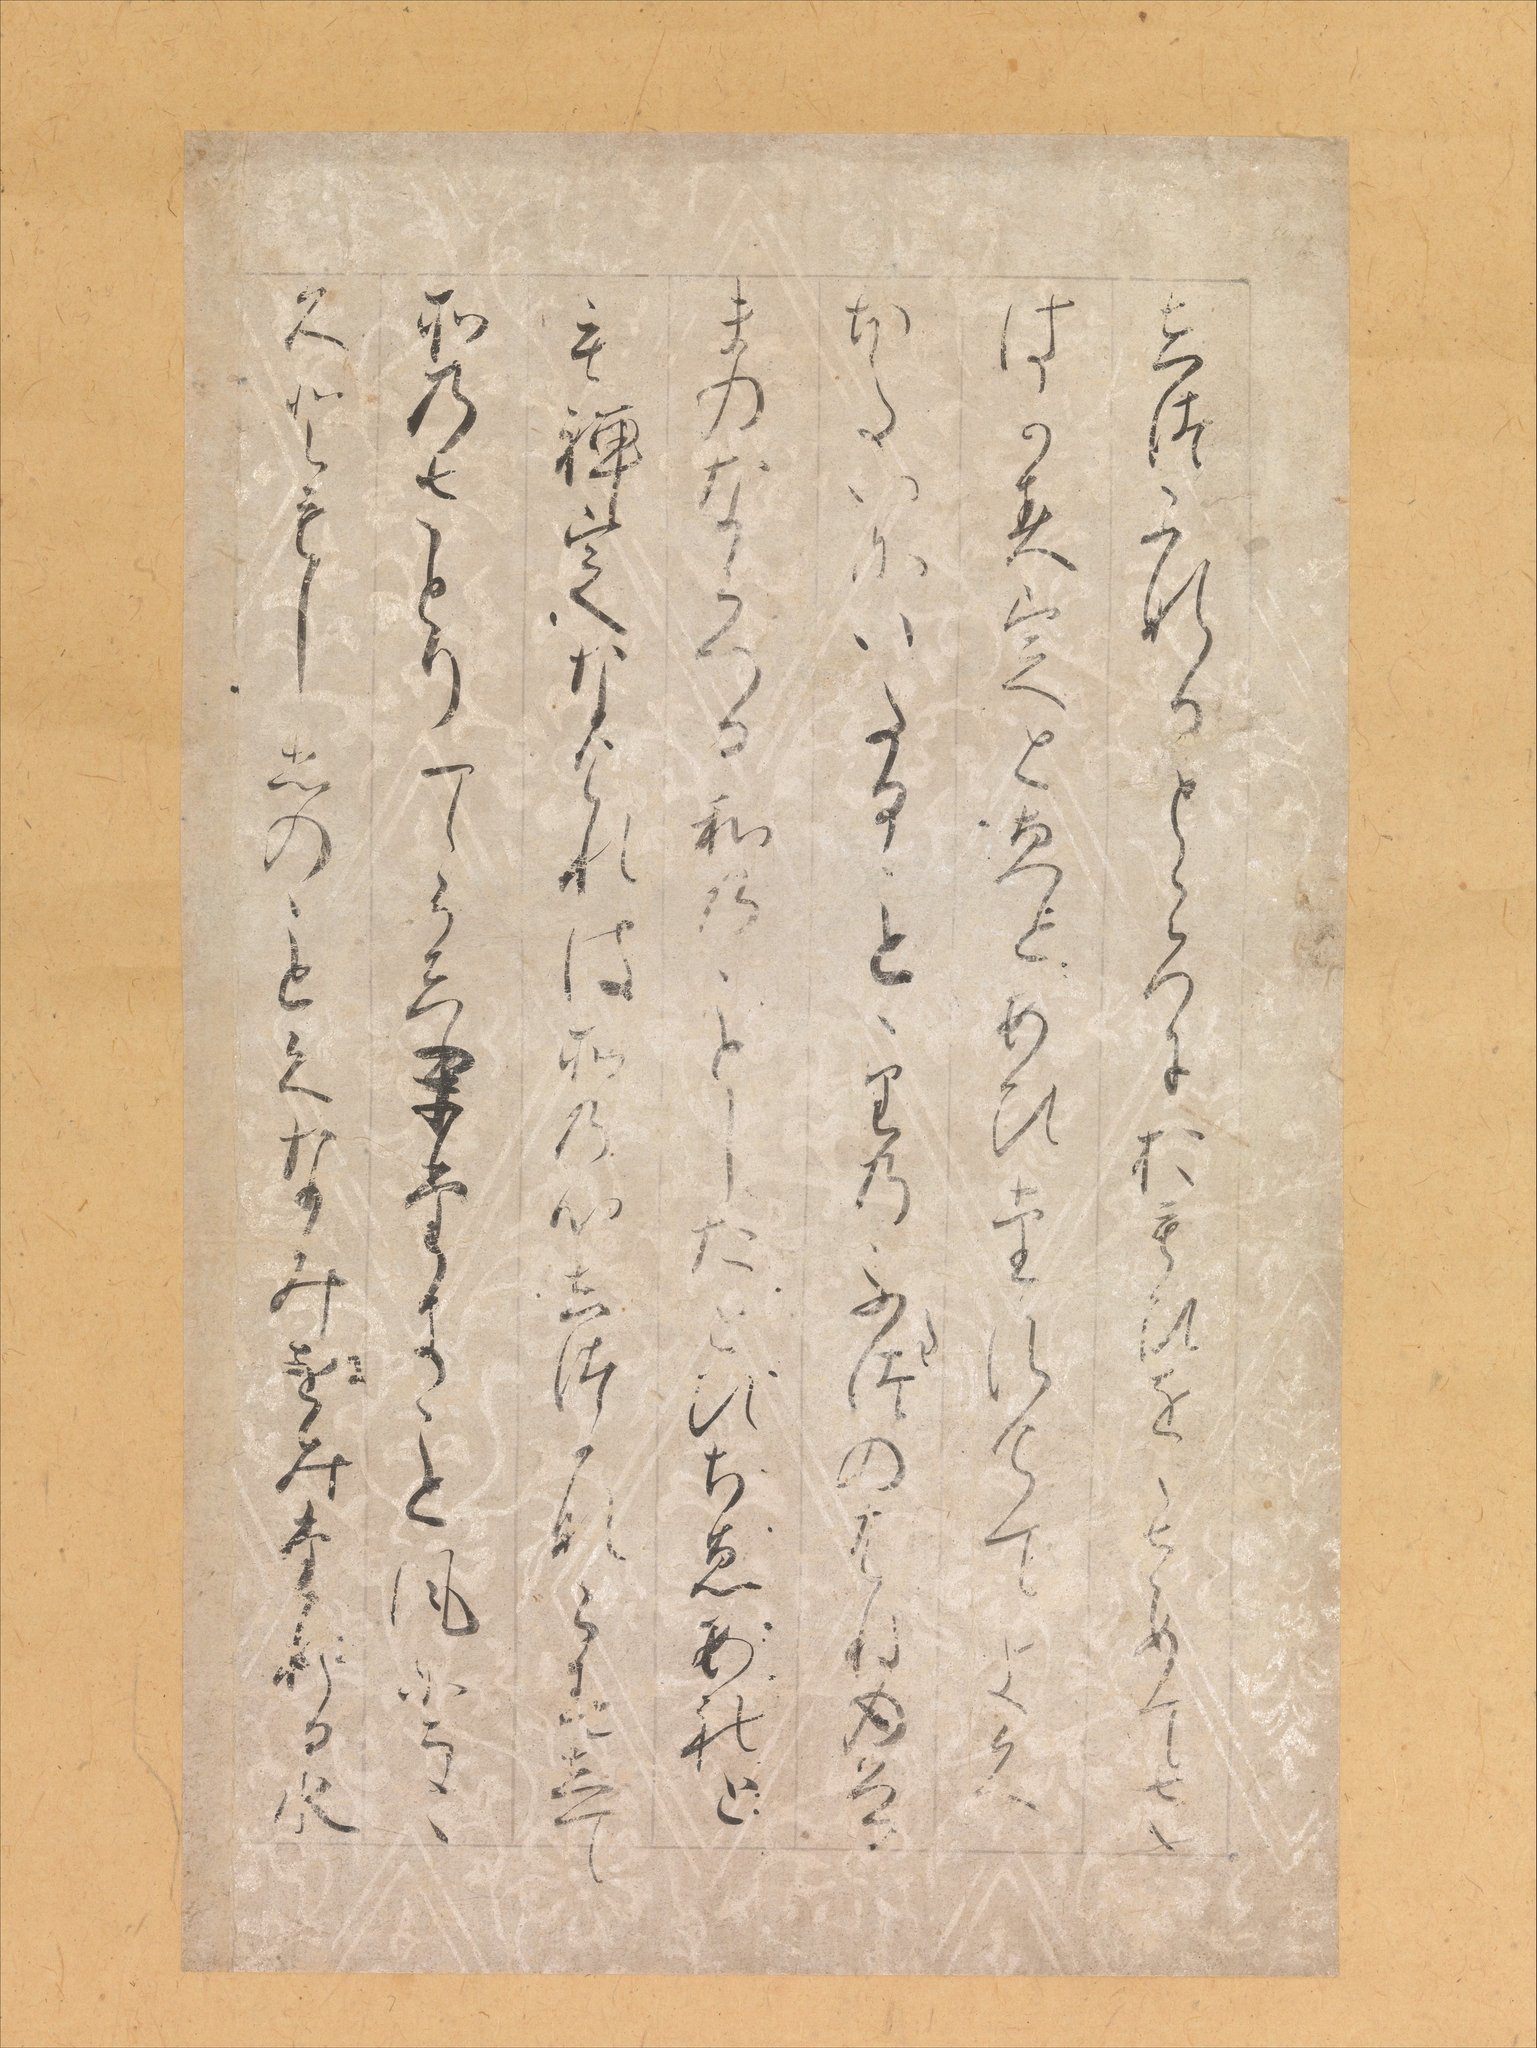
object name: hanging scroll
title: Page from Illustrations and Explanations of the Three Jewels (Sanbō e-kotoba), one of the “Tōdaiji Fragments” (Tōdaiji-gire)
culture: japanese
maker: minamoto no toshiyori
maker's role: artist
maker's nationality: japanese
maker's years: 1055-1129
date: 1120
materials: ink, paper